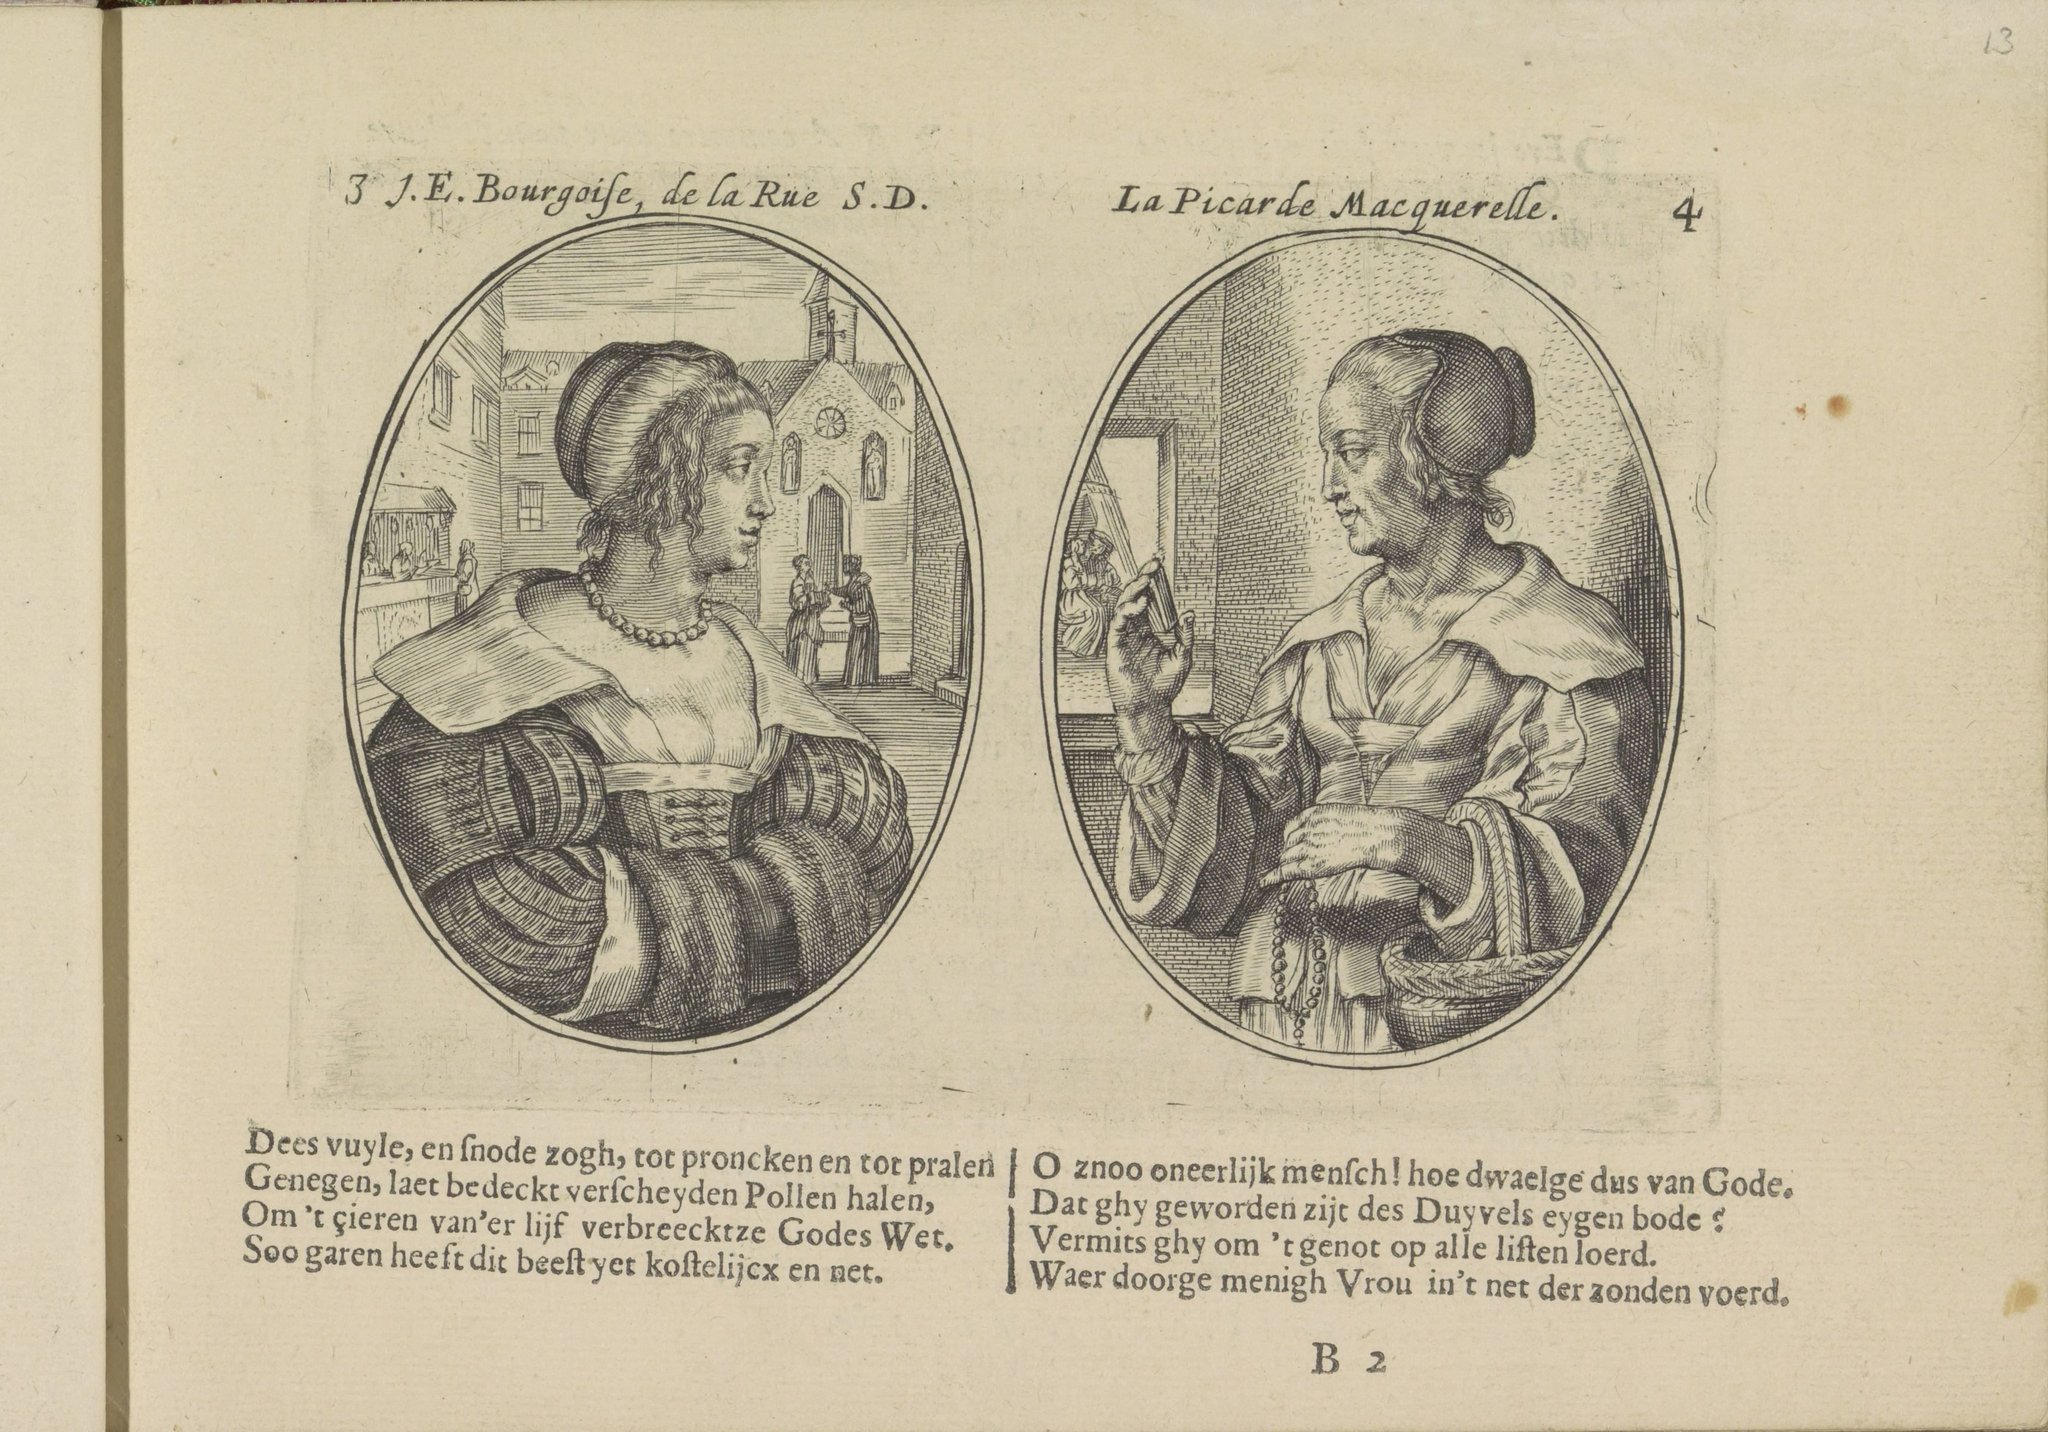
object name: print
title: Les abus du mariage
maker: crispijn van de passe (ii)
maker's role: draughtsman, print maker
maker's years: 1594-1670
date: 1641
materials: paper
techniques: engraving, letterpress printing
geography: amsterdam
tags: female sex; woman, stall, booth (~ market), couple of lovers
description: Twee voorstellingen op een albumblad. Links het fictieve portret van een burgervrouw uit de straat van S.D. Op de achtergrond een kerkgebouw, twee pratende vrouwen en een marktkraam. Rechts een koppelaarster (Jacquemijn Picard) met om haar arm een mand en in haar hand een rozenkrans. Op de achtergrond een verliefd stelletje. Daaronder twee kwatrijnen in het Nederlands. De prent maakt deel uit van een album.